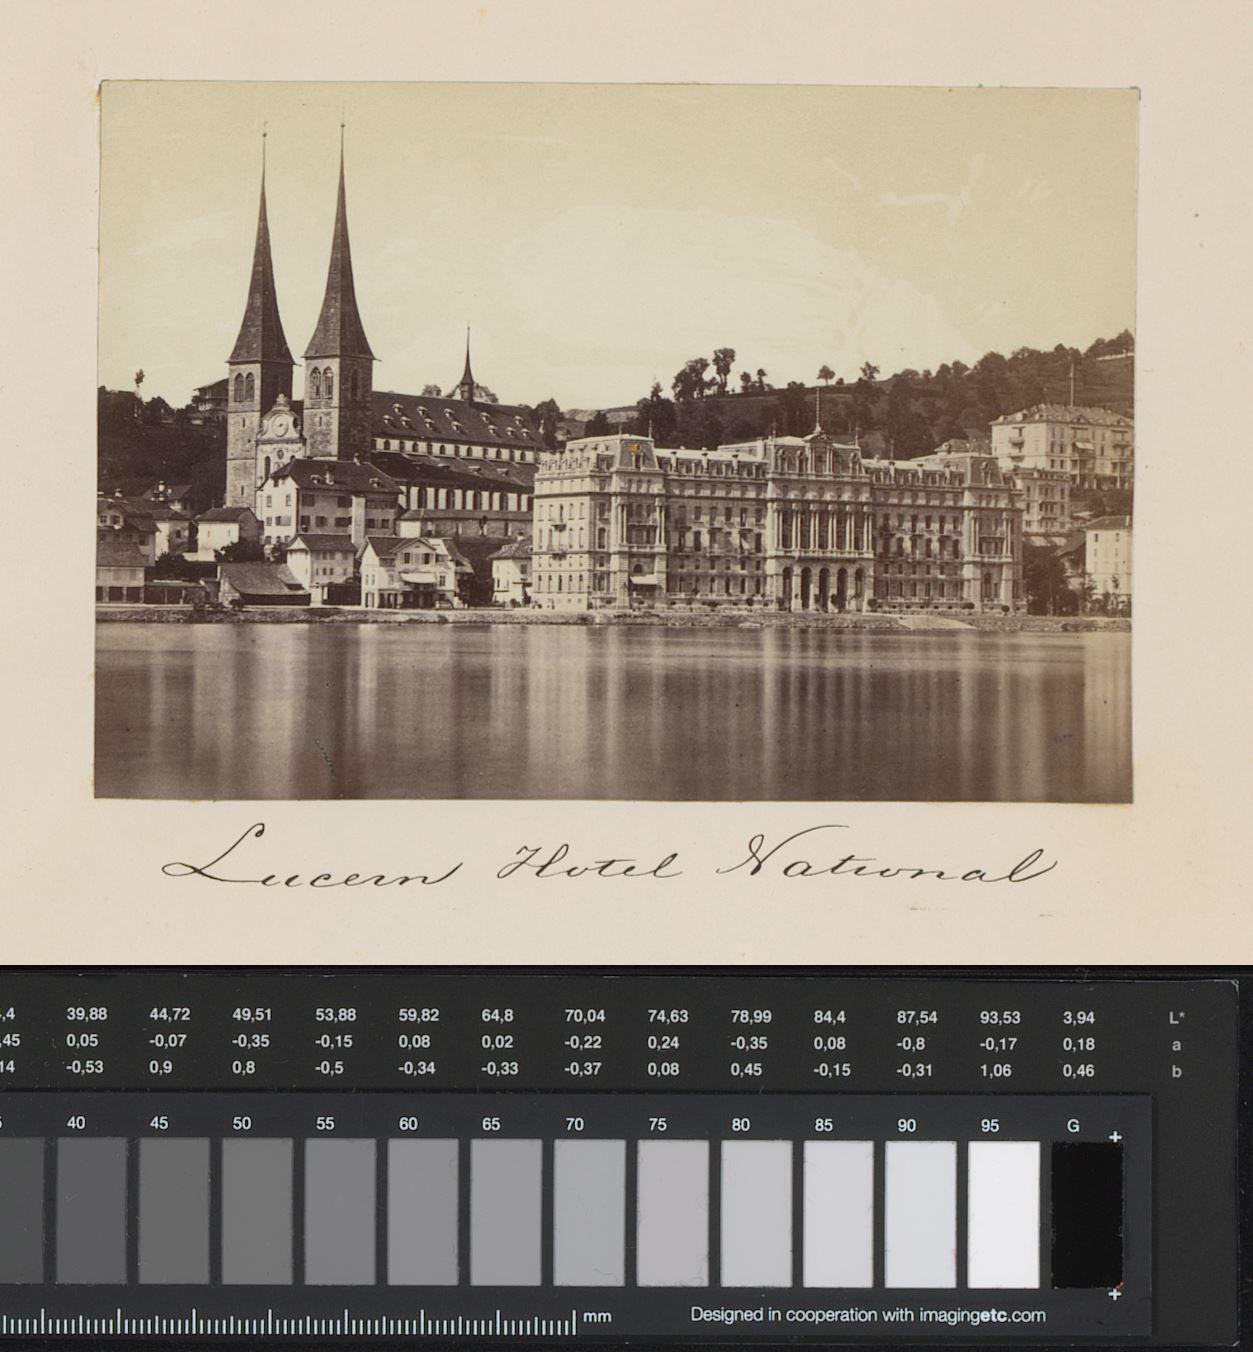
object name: album leaf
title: Gezicht op een hotel te Luzern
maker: Anonymous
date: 1860-1900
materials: photographic support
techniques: albumen print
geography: lucerne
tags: city-view in general; 'veduta', hotel, hostelry, inn